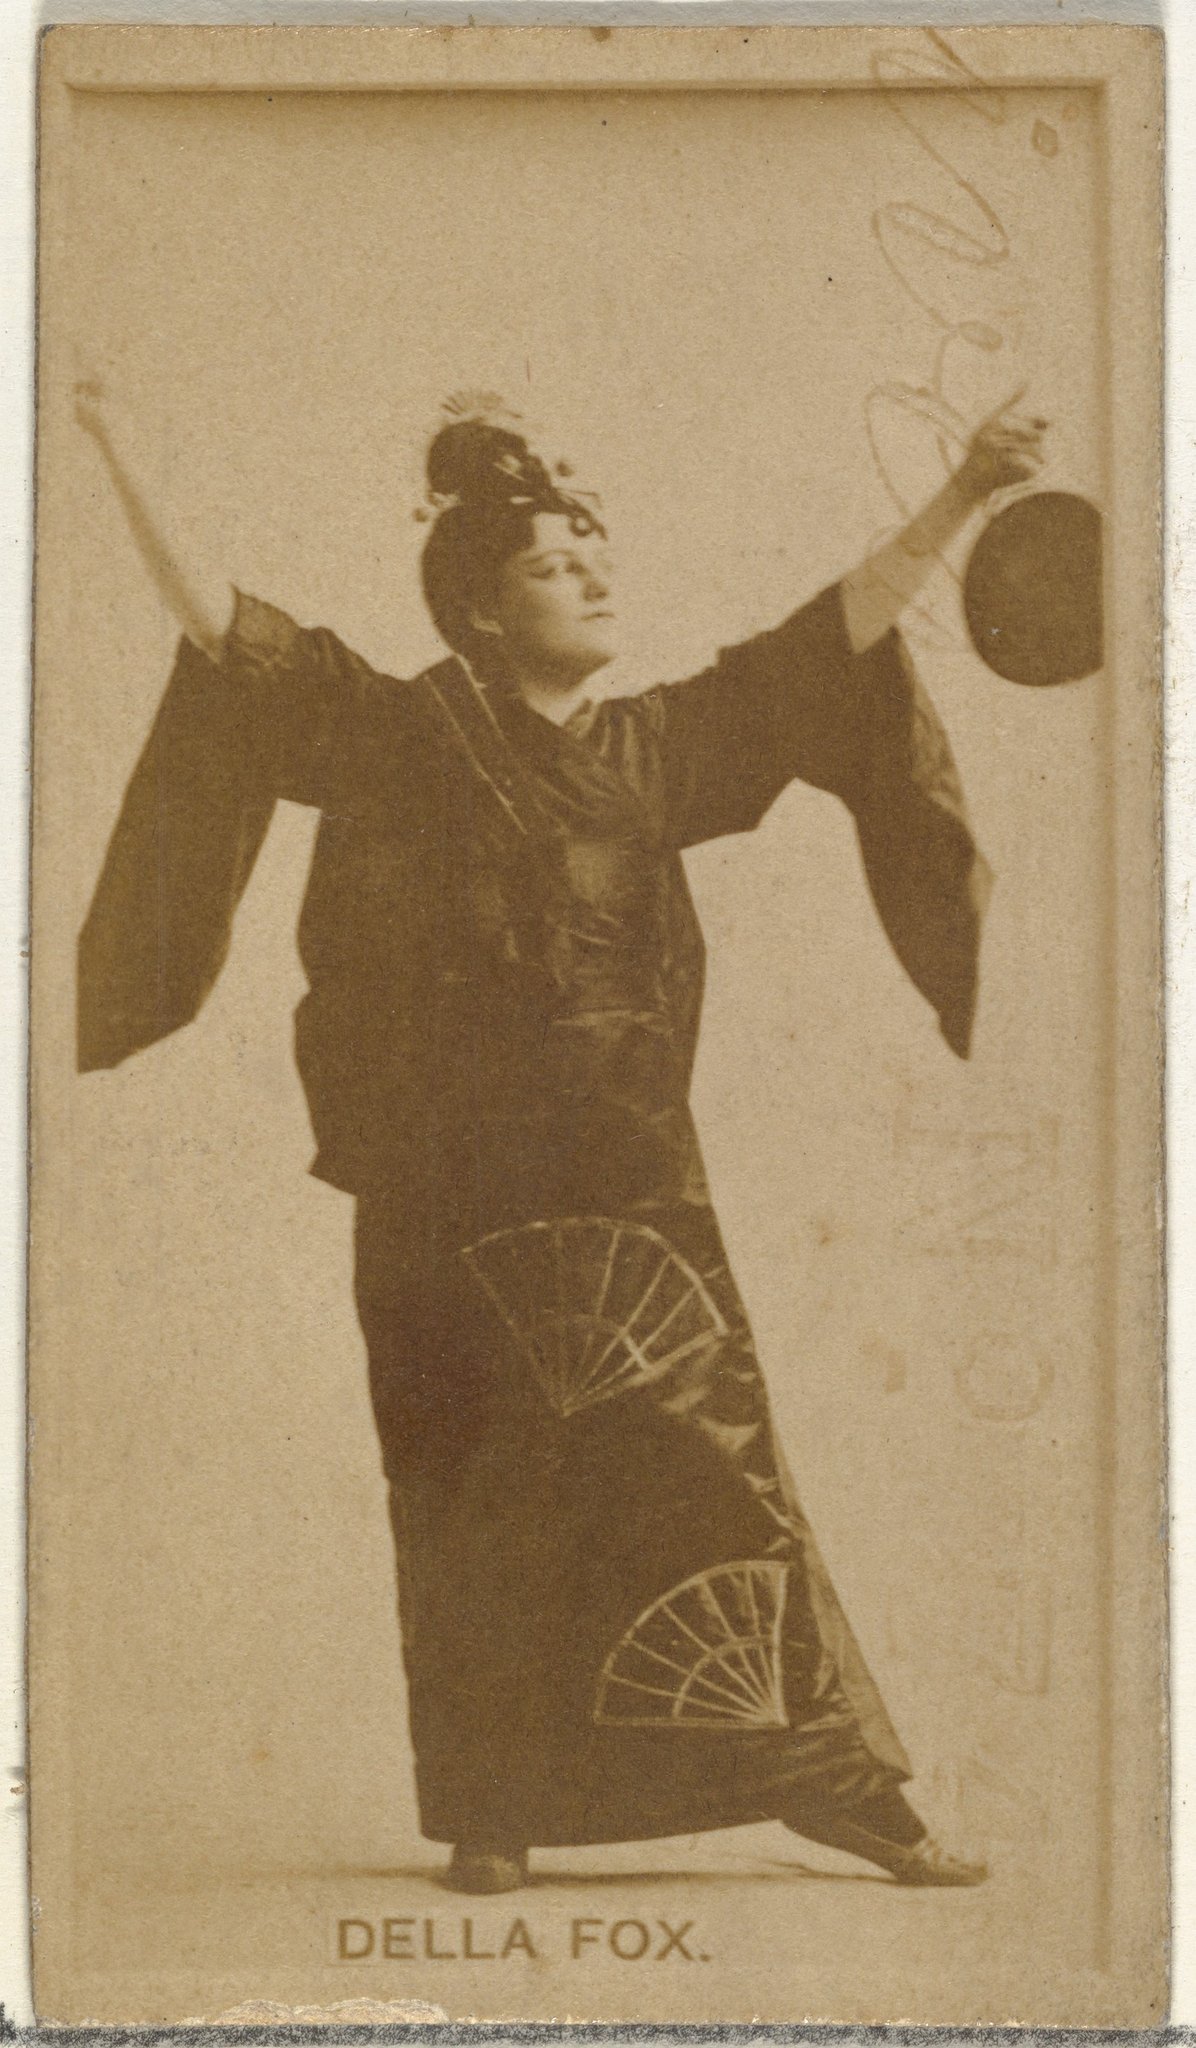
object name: photograph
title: Della Fox, from the Actors and Actresses series (N145-8) issued by Duke Sons & Co. to promote Duke Cigarettes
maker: w. duke, sons & co.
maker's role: publisher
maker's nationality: american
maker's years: 1870-1920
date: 1891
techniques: albumen silver print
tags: portraits,women,actresses